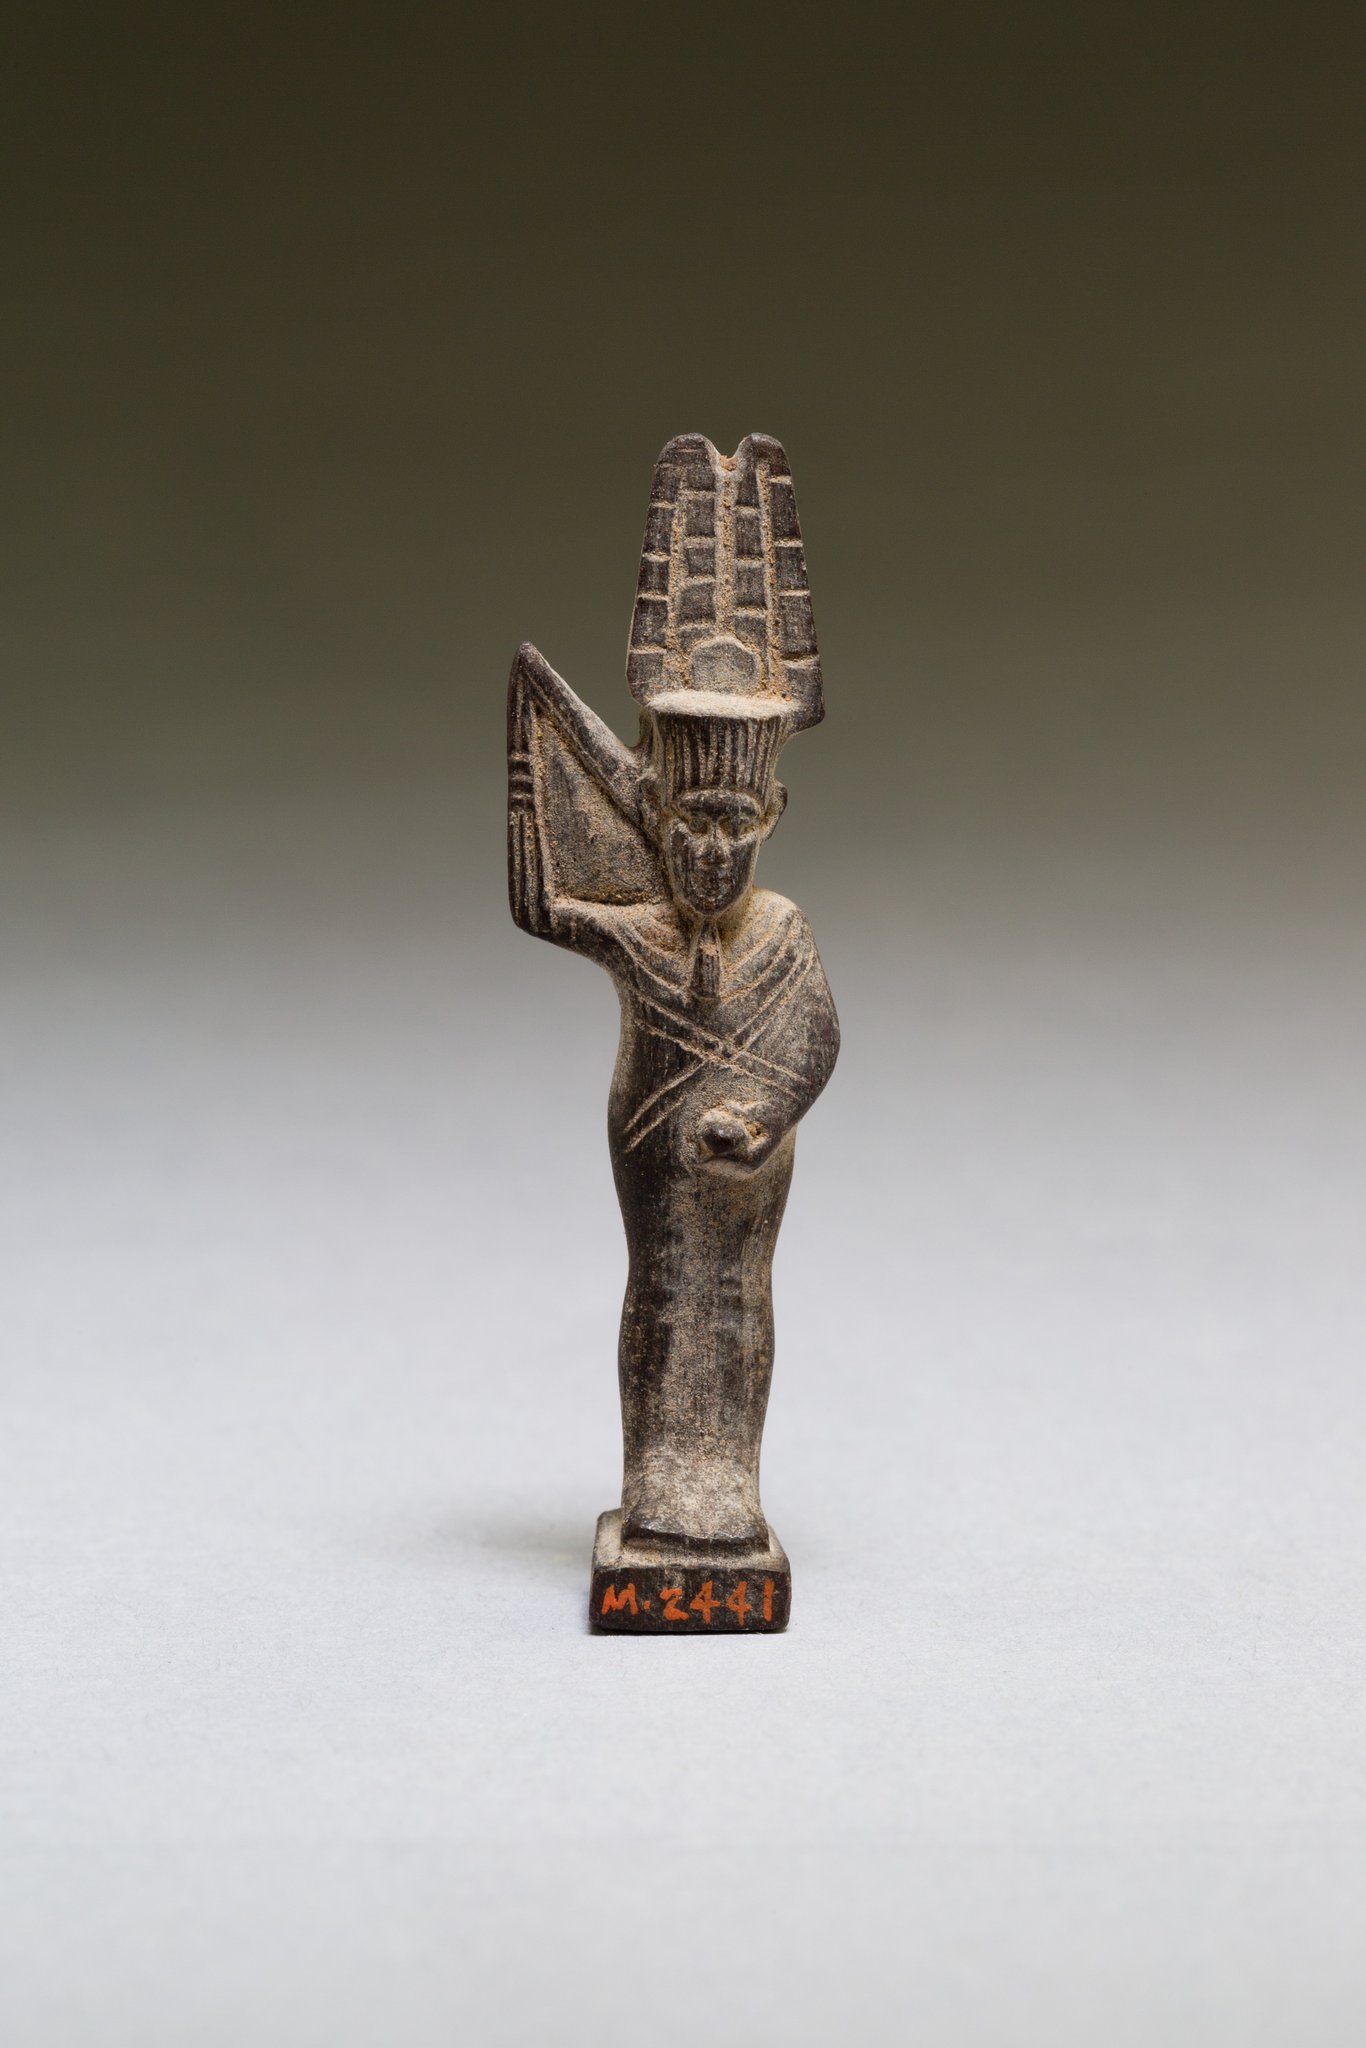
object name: figurine, min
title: Min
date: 664-630 BCE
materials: wood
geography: egypt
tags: goddess